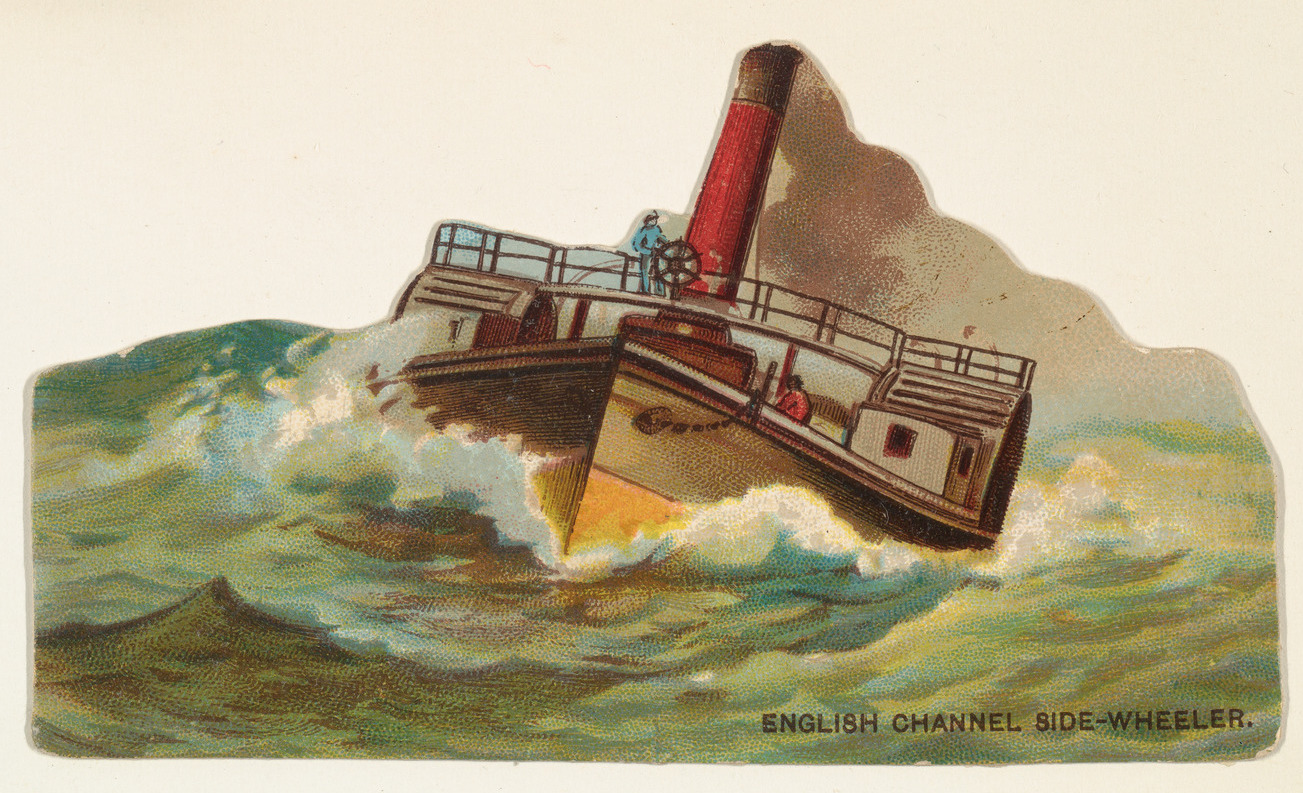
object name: print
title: English Channel Side-Wheeler, from the Types of Vessels series (N139) issued by Duke Sons & Co. to promote Honest Long Cut Tobacco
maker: w. duke, sons & co.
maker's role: publisher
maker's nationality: american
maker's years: 1870-1920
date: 1889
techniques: color lithograph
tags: boats